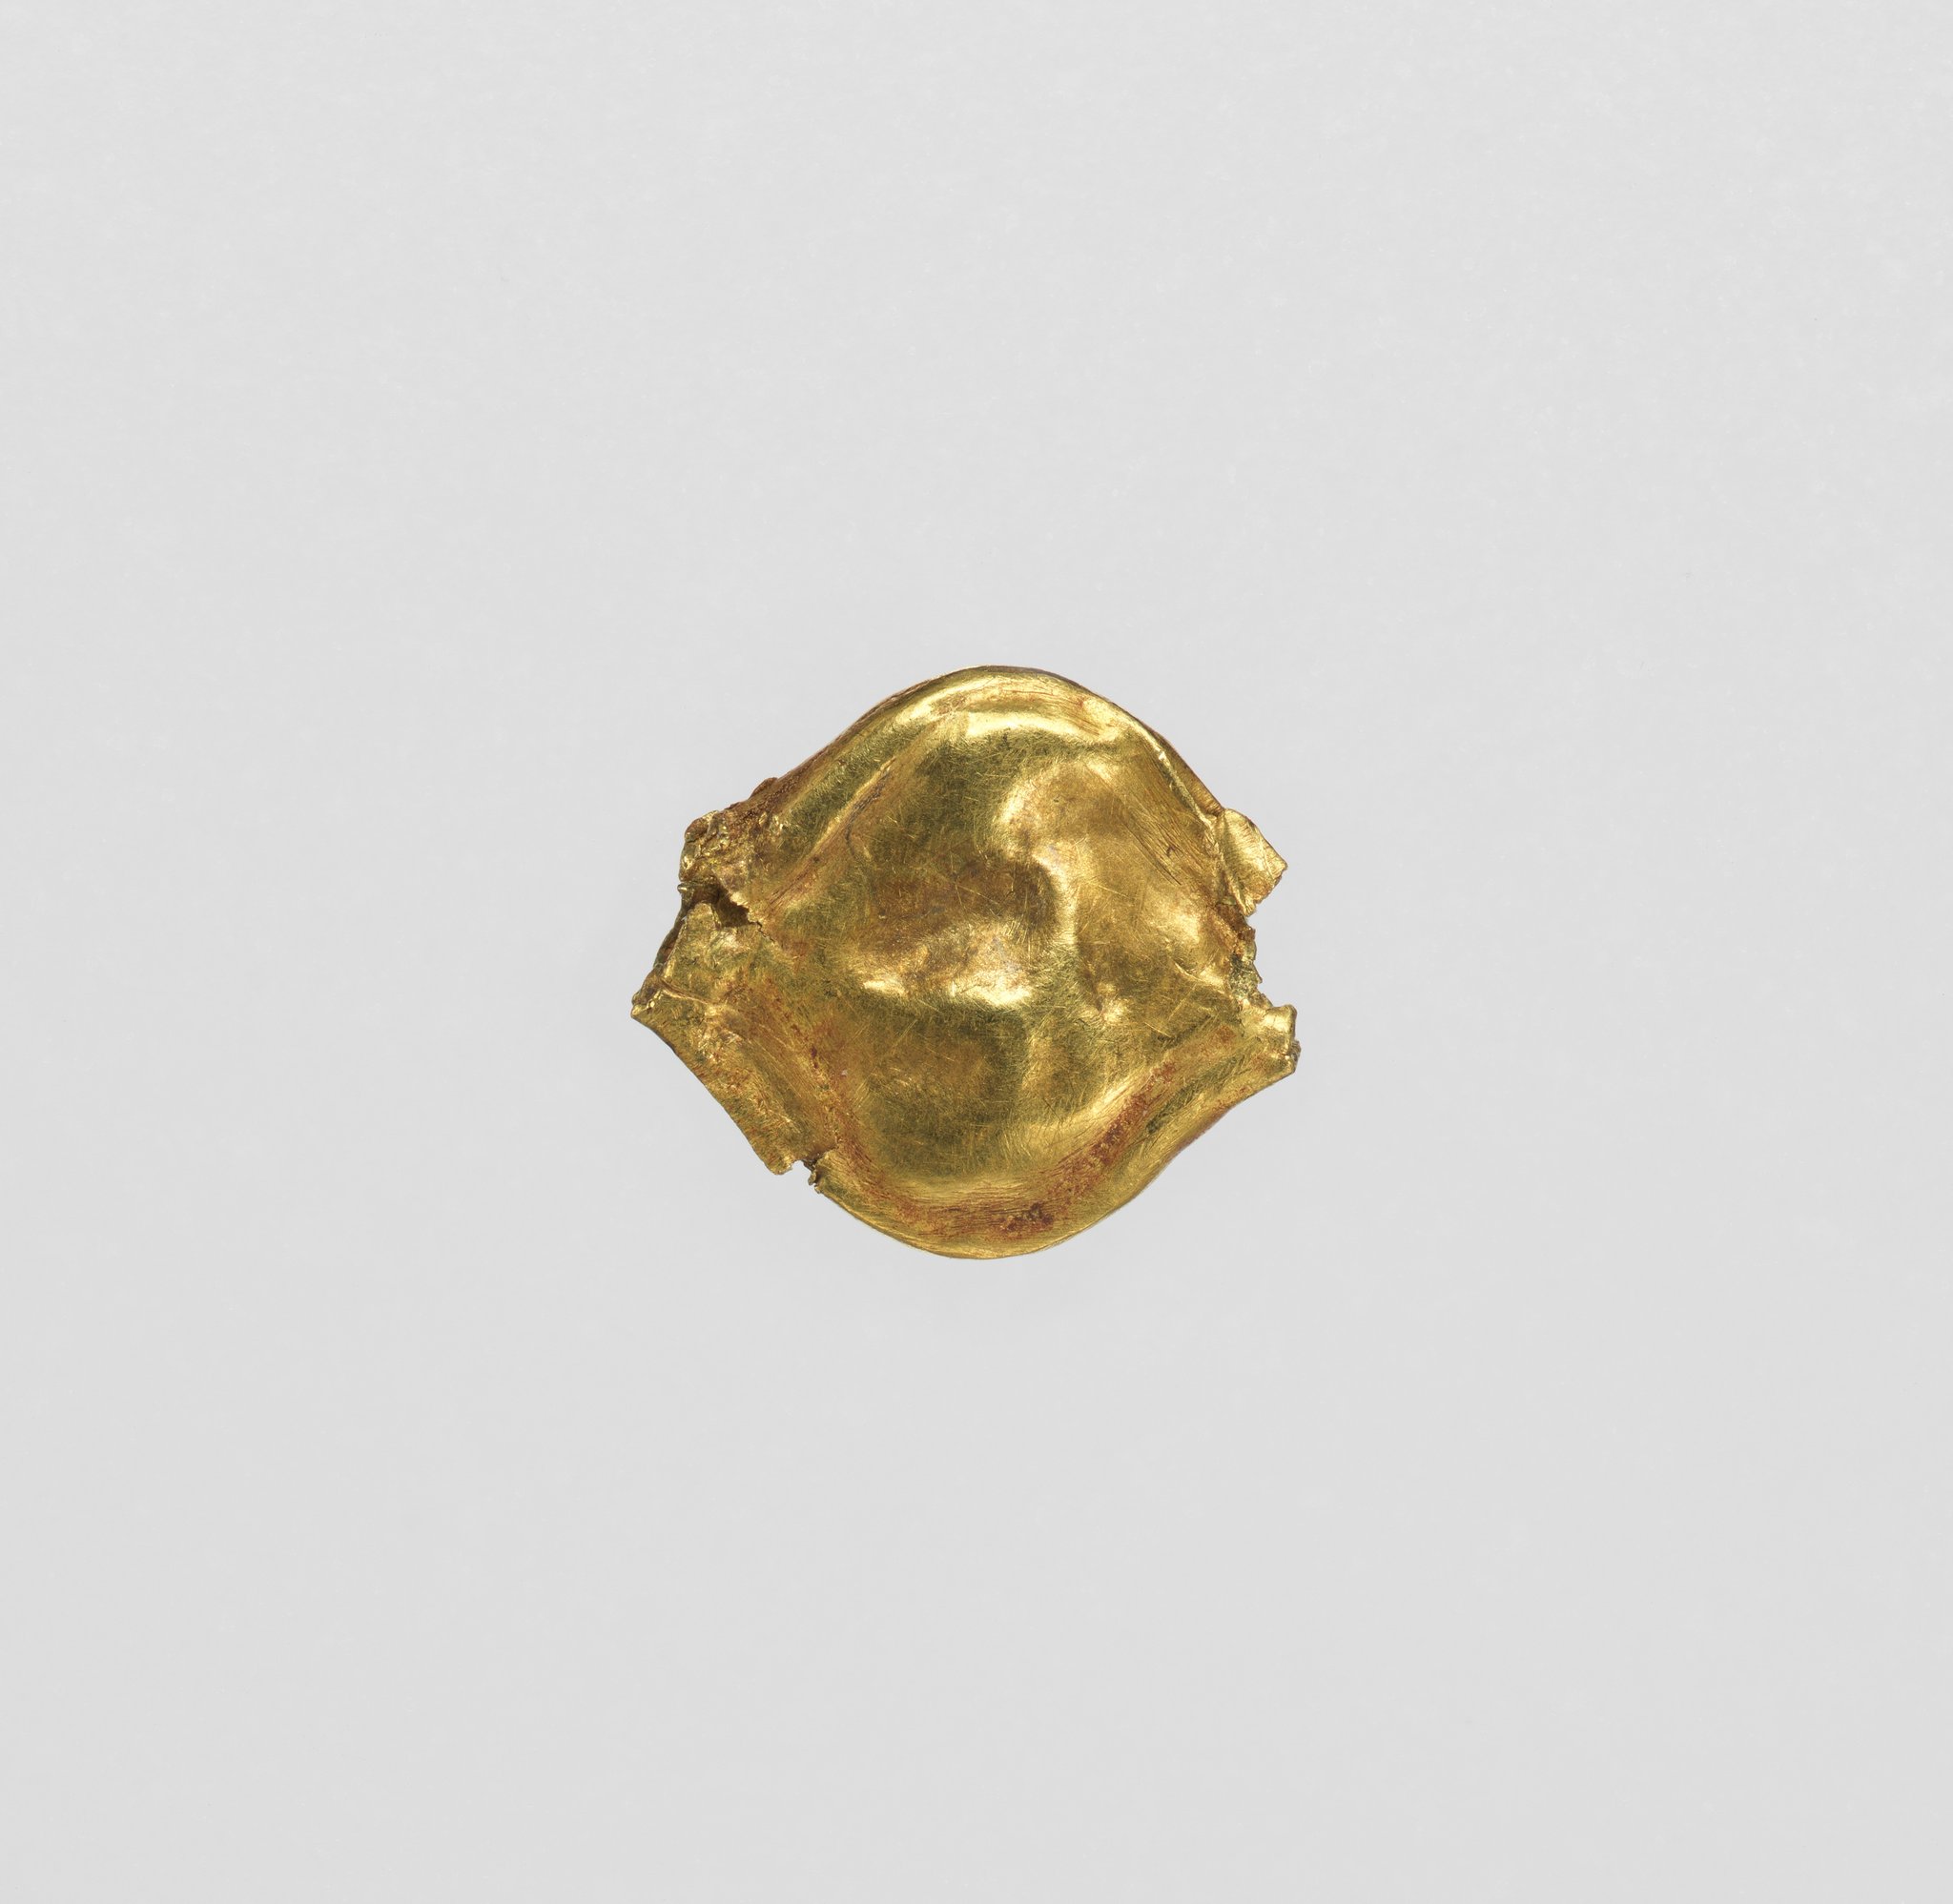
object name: bead, acacia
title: One acacia seed bead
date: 1878-1840 BCE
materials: gold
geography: memphite region